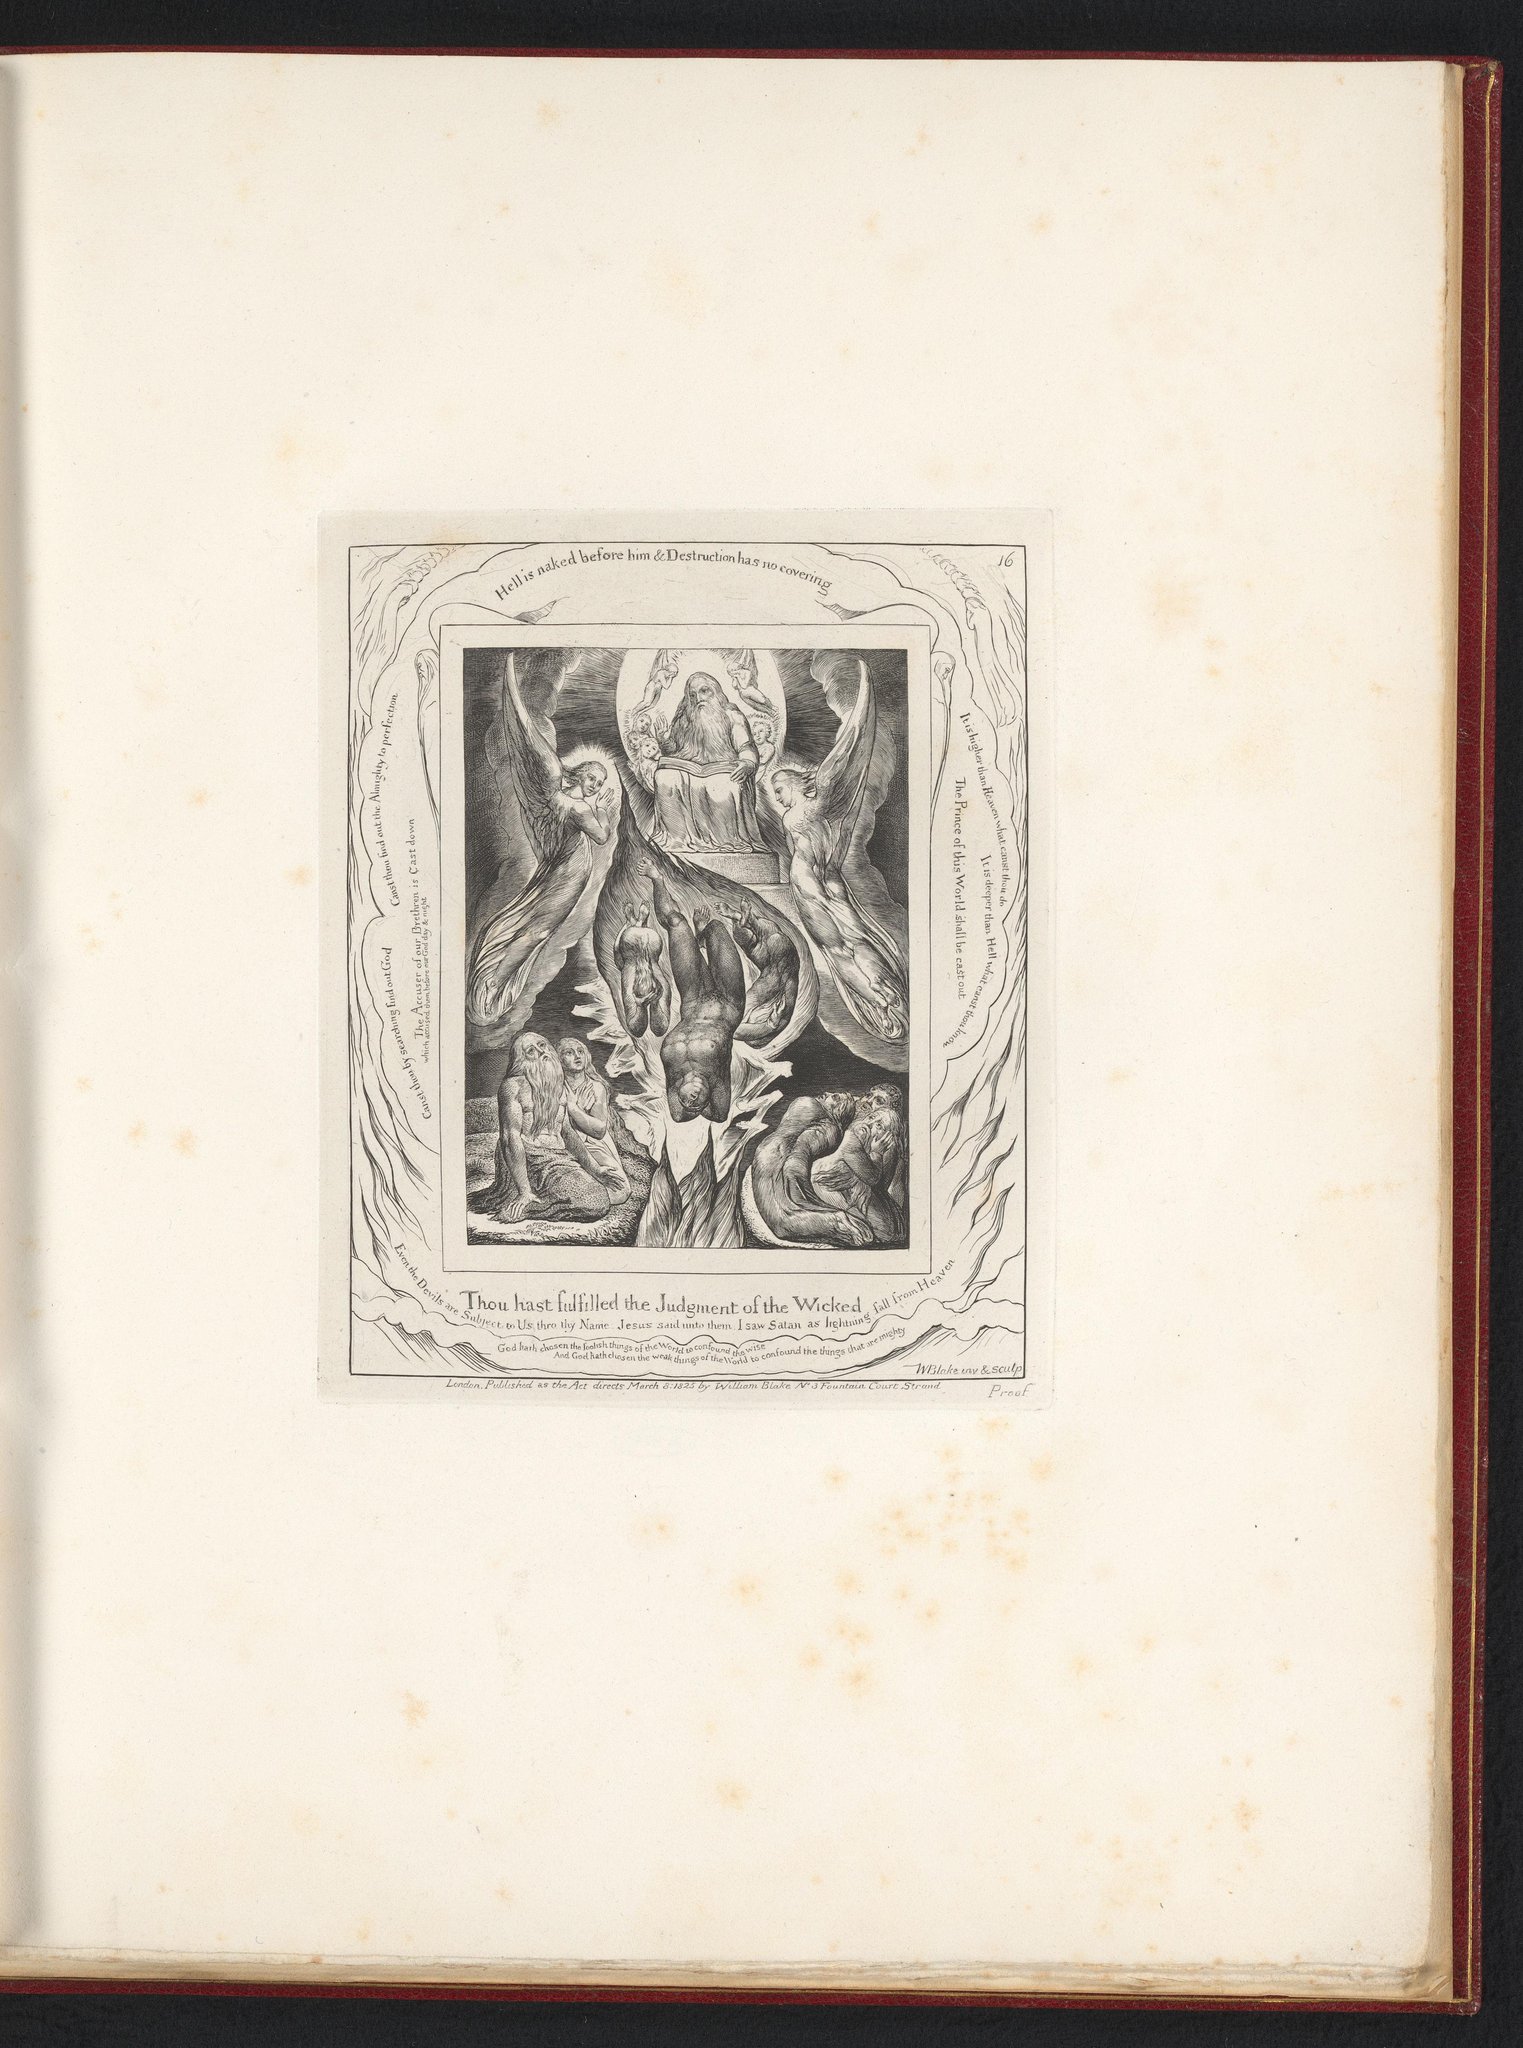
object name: album leaf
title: Jobs voorspoed hersteld en de val van Satan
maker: william blake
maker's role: print maker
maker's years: 1757-1827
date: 1825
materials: paper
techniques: engraving, etching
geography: london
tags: job's prosperity restored; the last part of his life (job 42:10-17), the fall of satan, fall of lucifer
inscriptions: collector's mark: Lugt 2228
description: Prent maakt deel uit van een serie van 21 prenten. Er bestaan 150 afdrukken van de serie met daarop 'proof'.